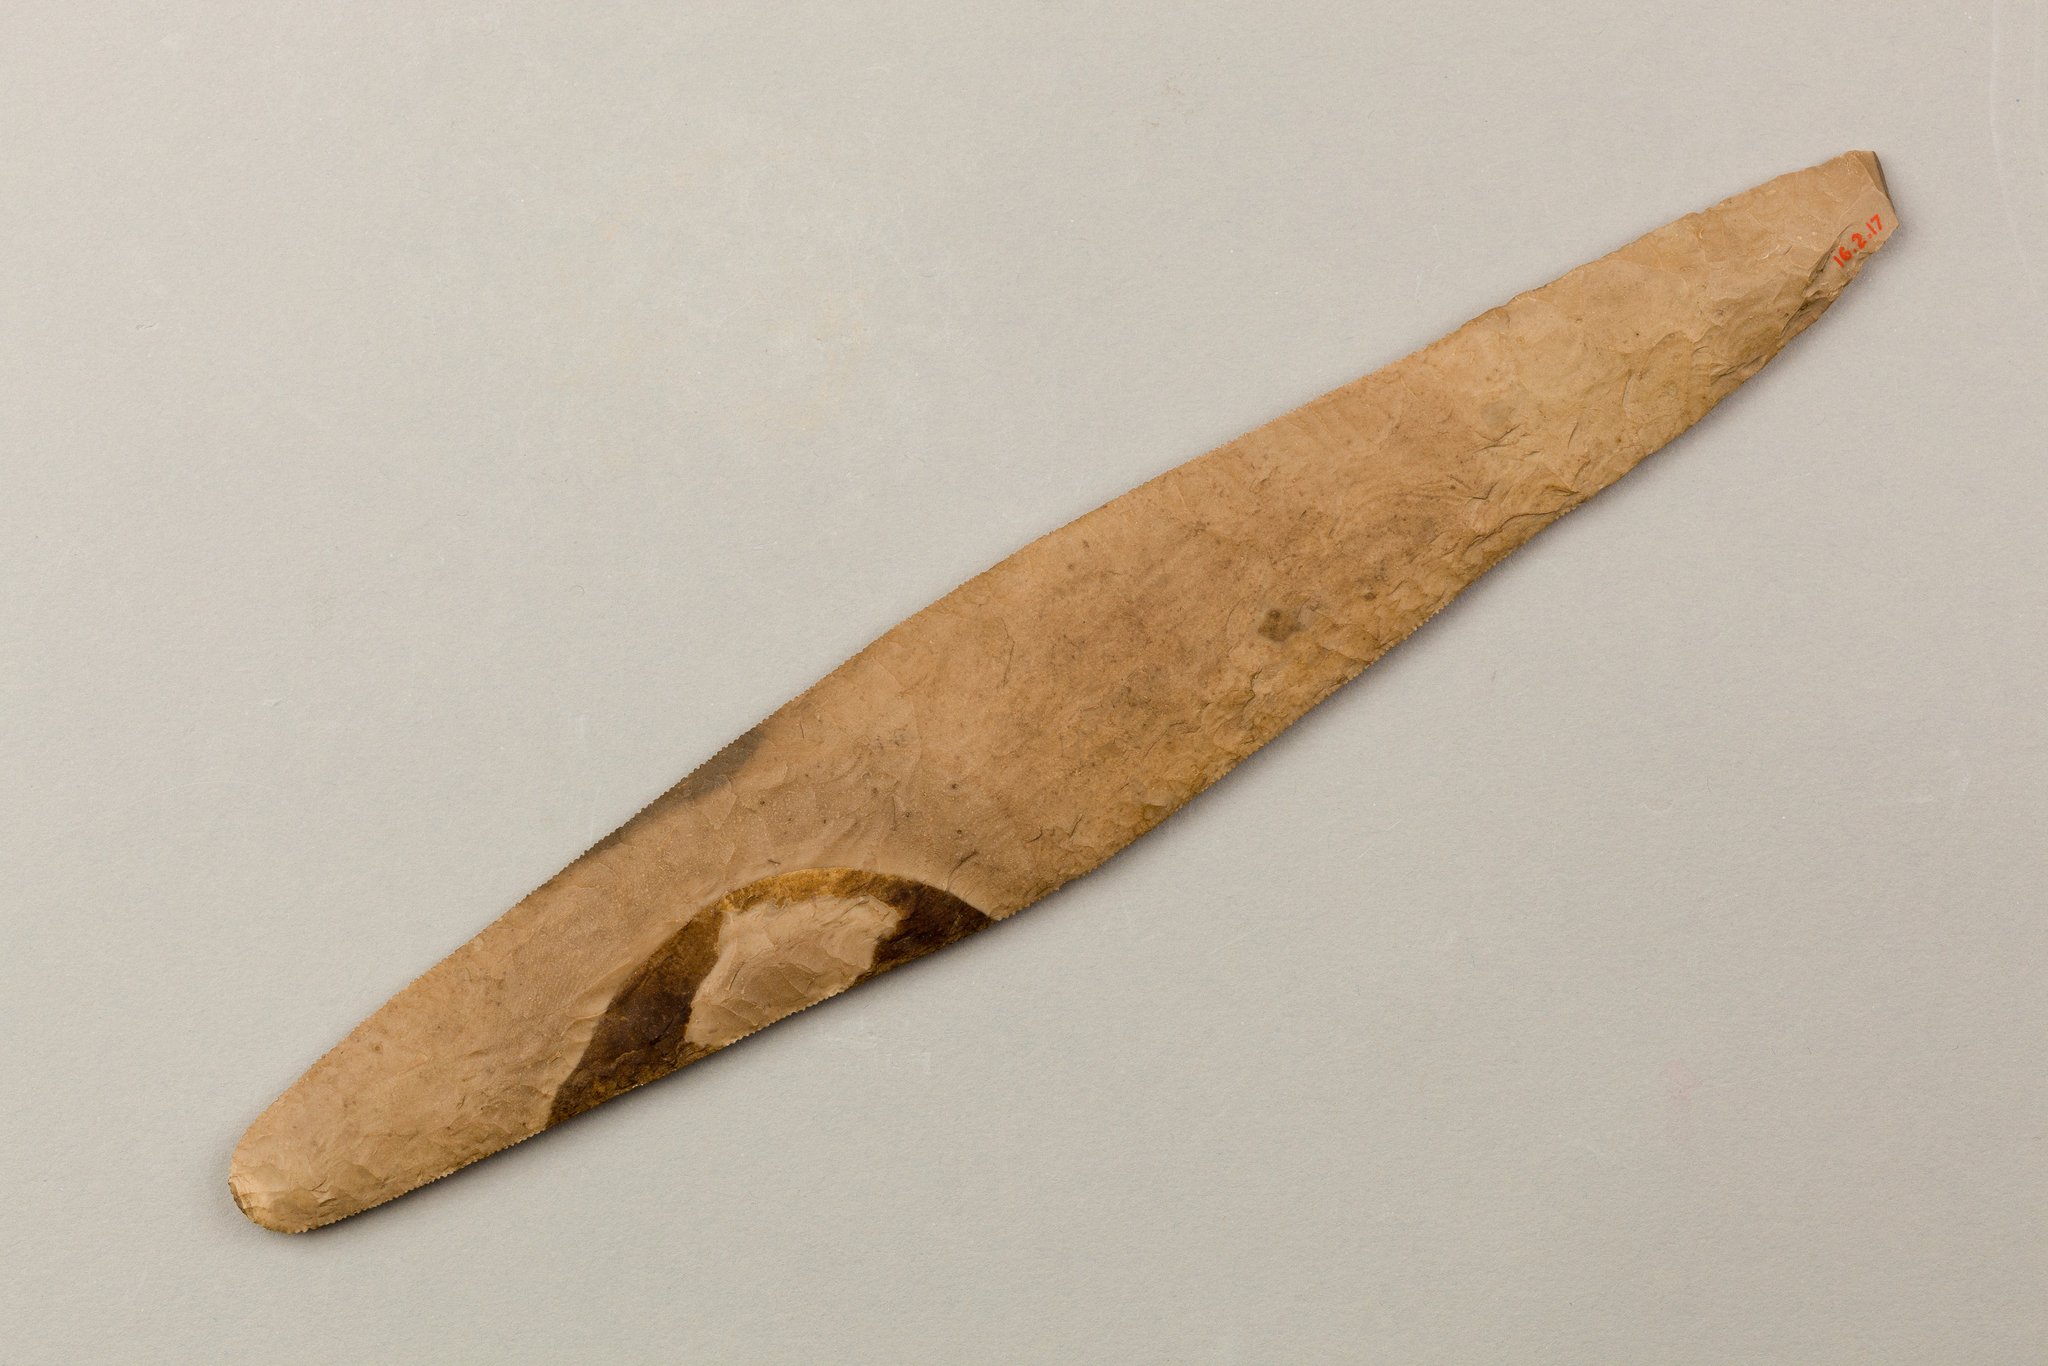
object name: knife, rhomboid, bifacial knife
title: Rhomboid-Shaped Bifacial Knife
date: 3850-2960 BCE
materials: stone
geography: egypt